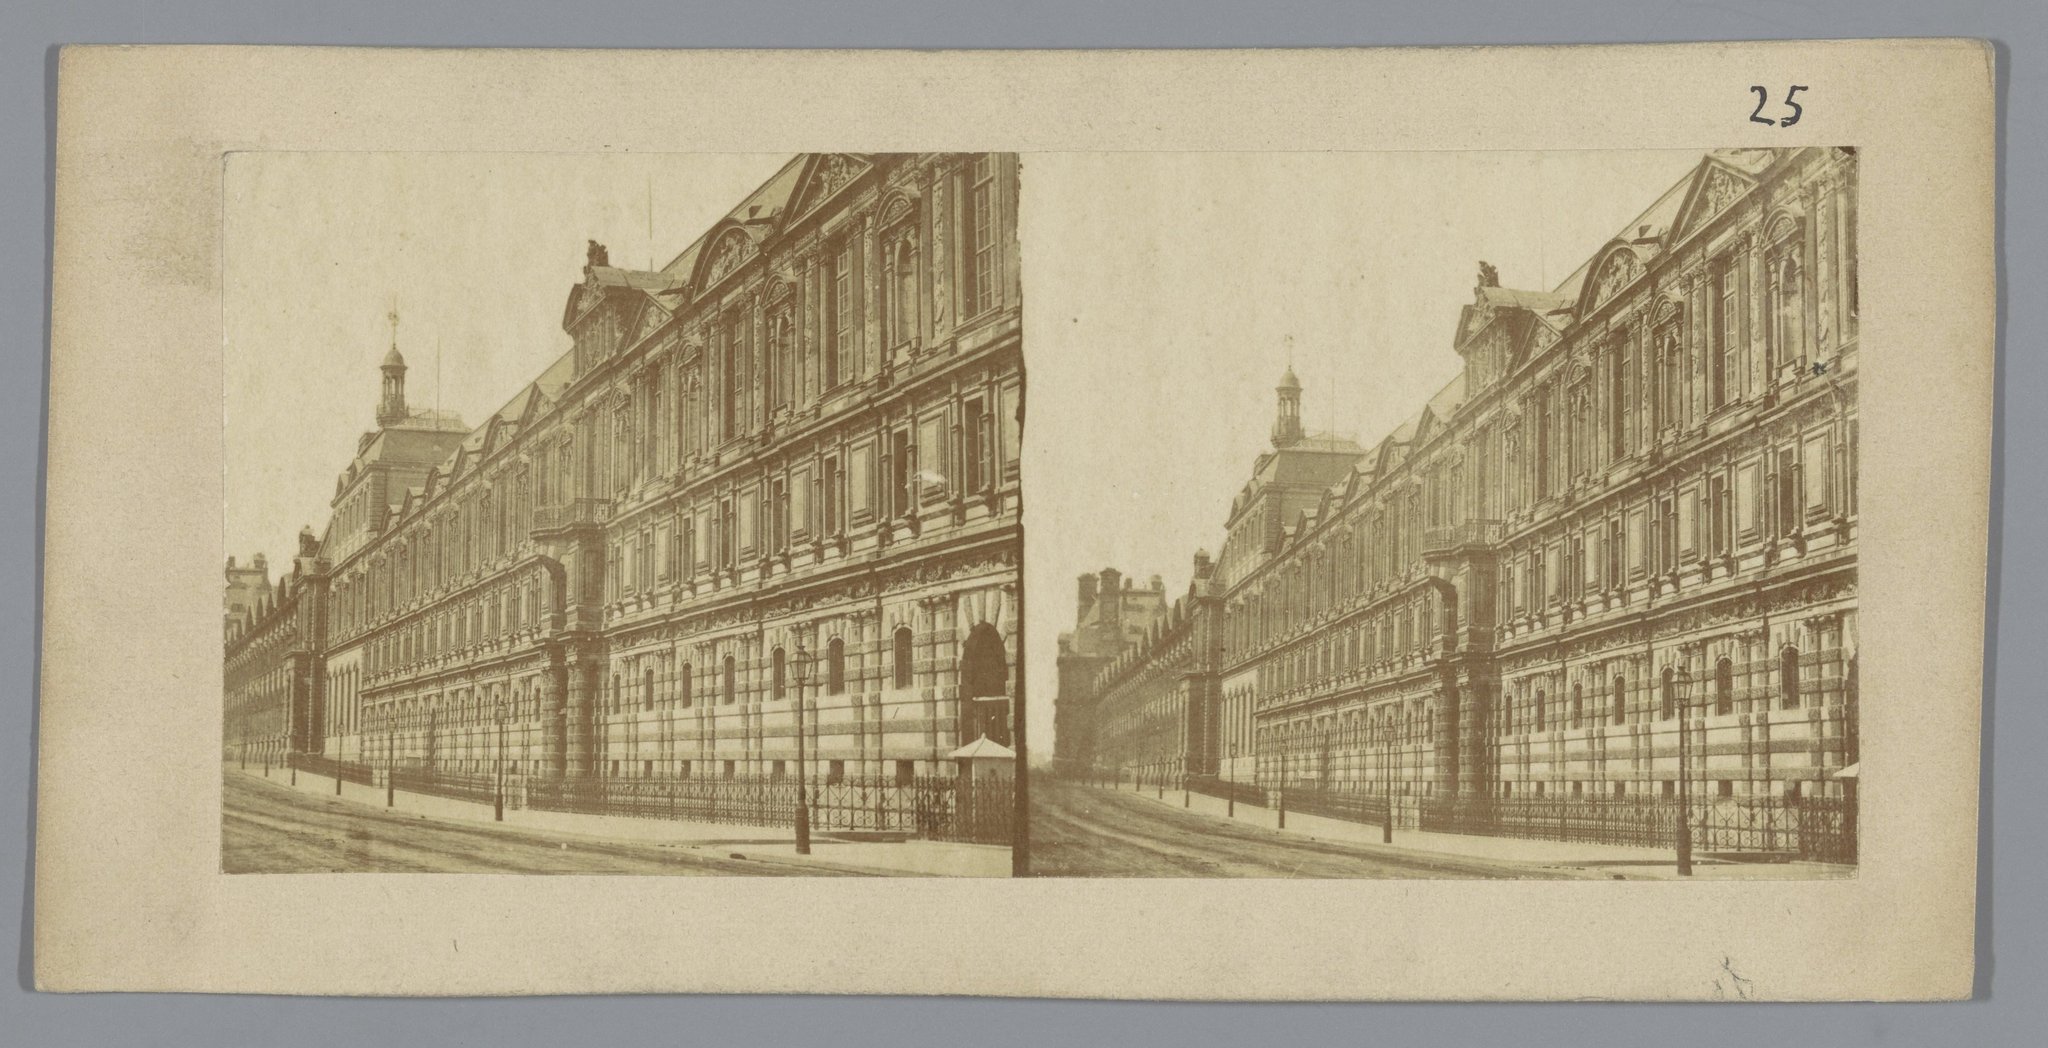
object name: stereograph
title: Les Tuileries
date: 1851-1871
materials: cardboard, paper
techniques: albumen print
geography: paris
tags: palace, tuileries palace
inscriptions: retailer's mark: ‘222, rue de Rivoli/ en face le Jardin des Tuileries./ Lecocq-Frêne/ Estampes Photographies/ Plans et Guides pour Voyageurs/ Vues pr Stéreoscopes.’, number: ‘25’